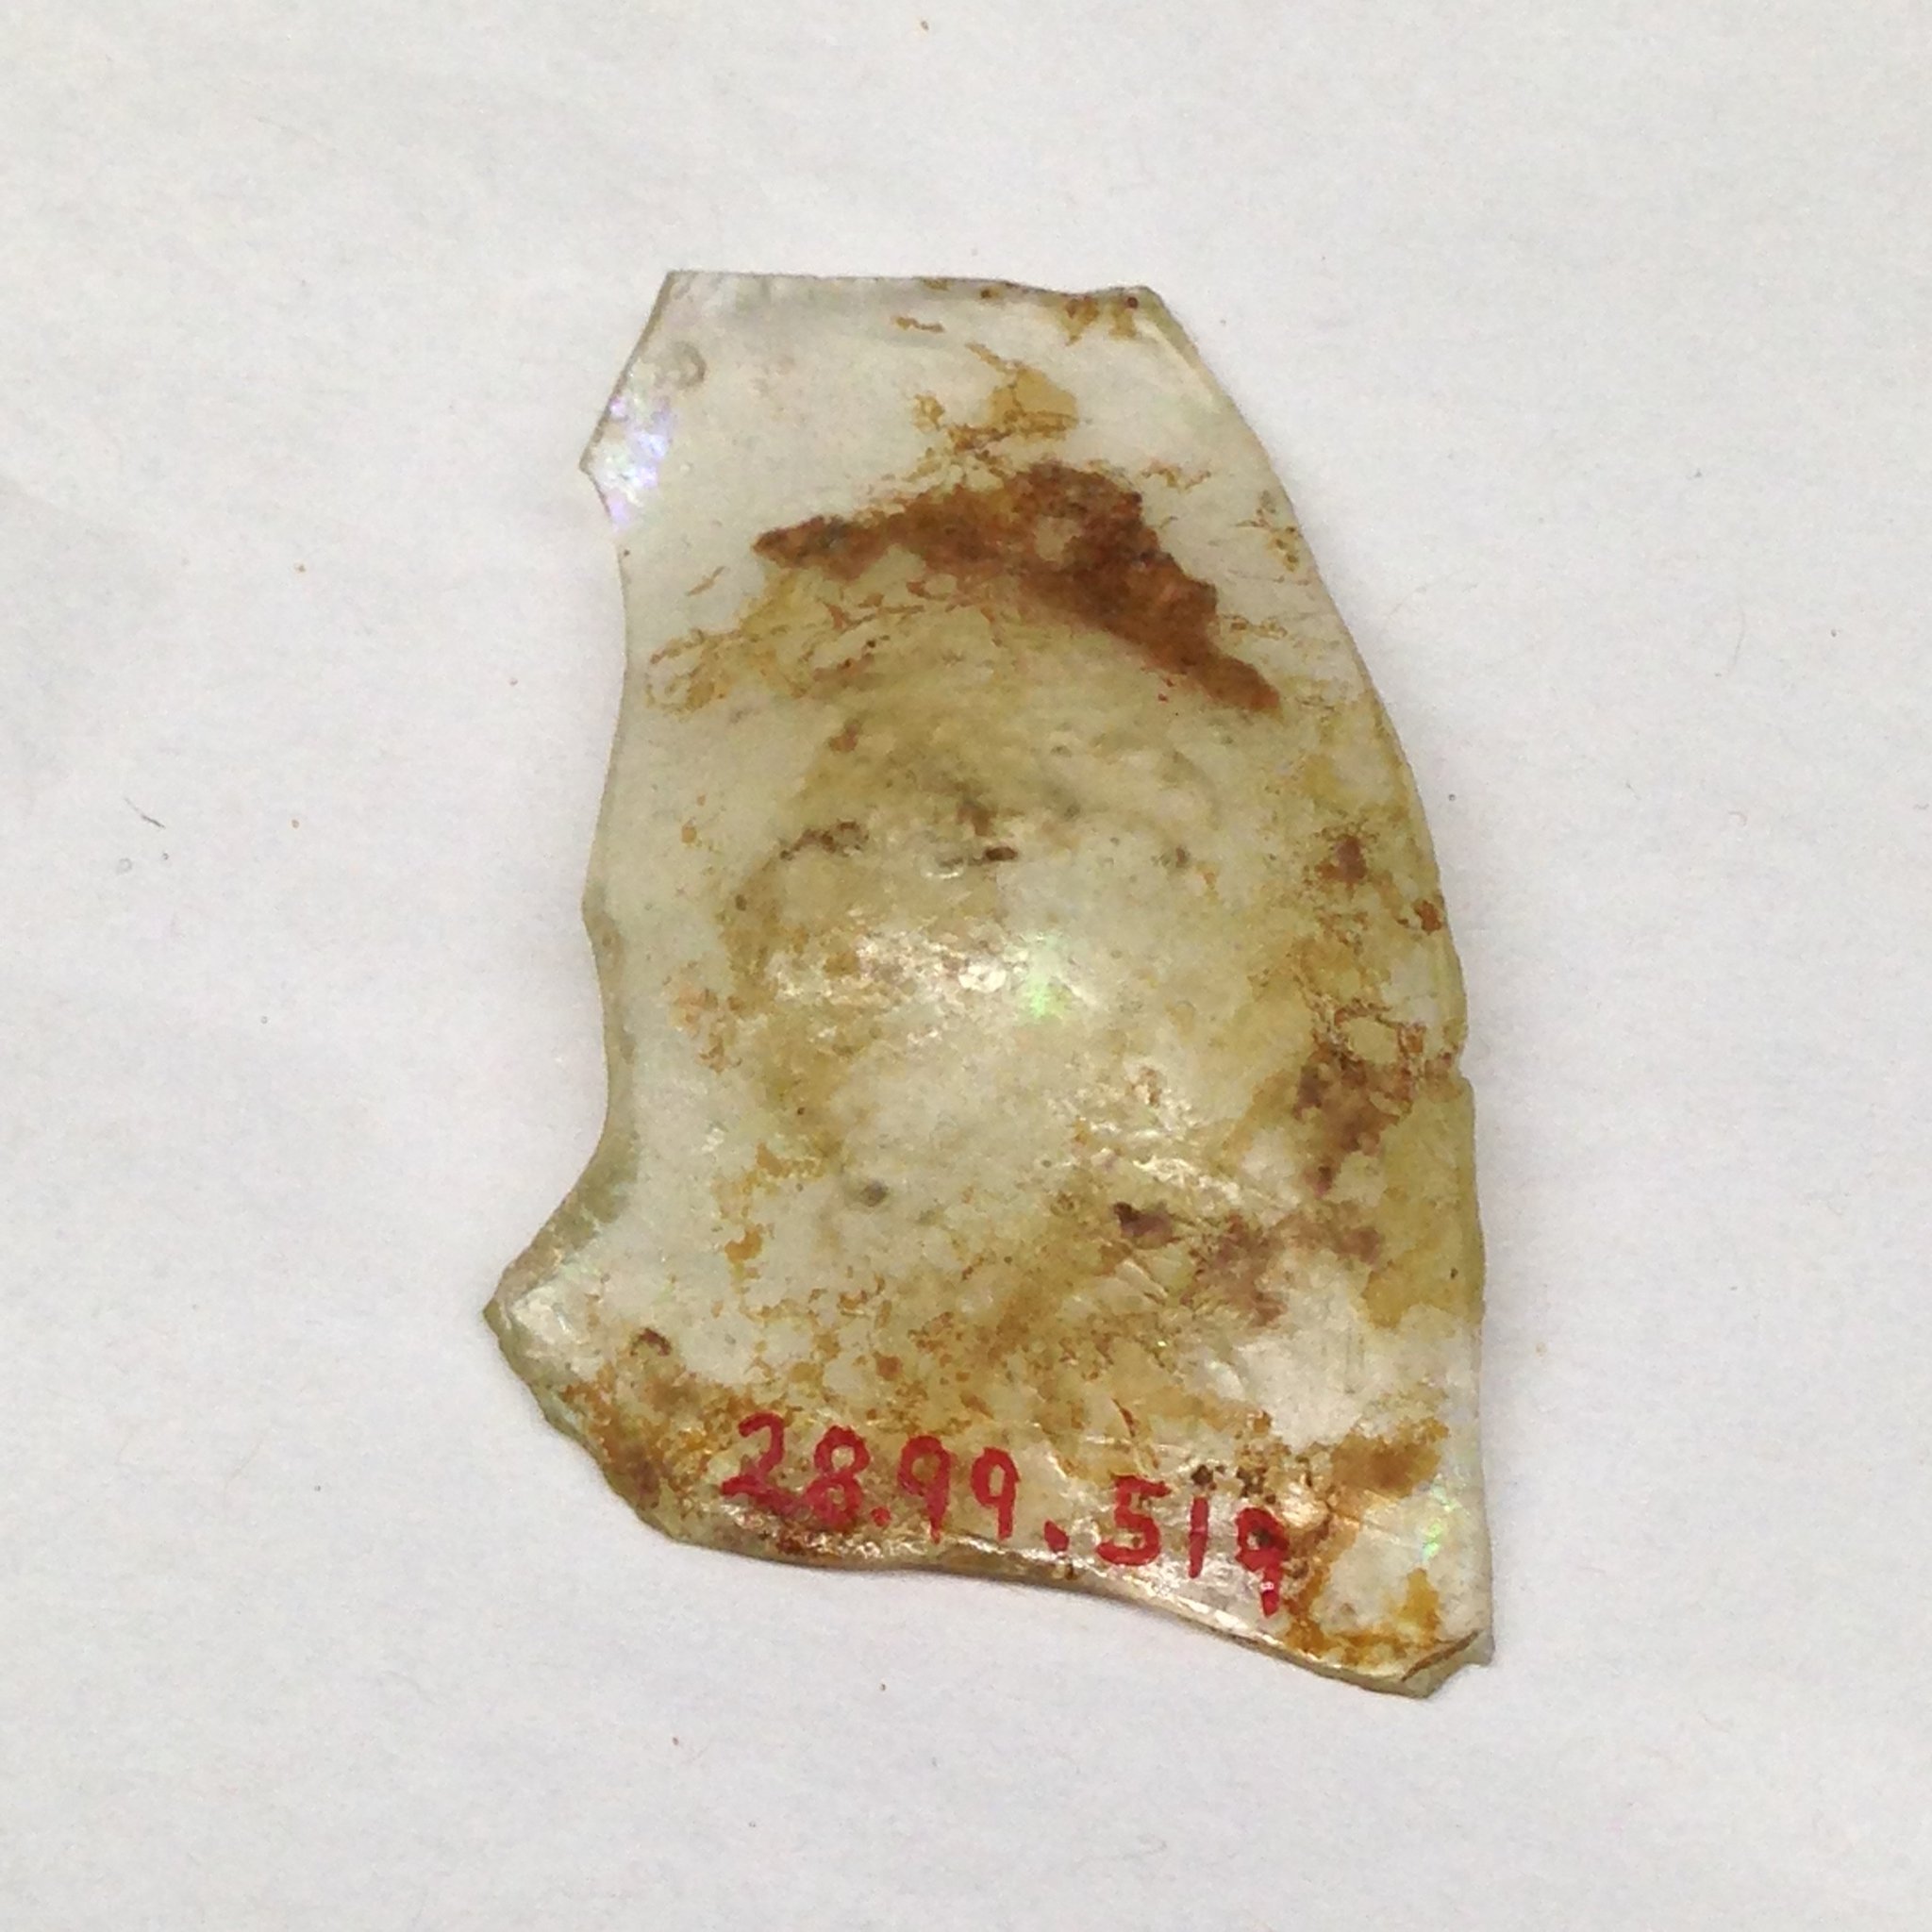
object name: fragment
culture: european or middle eastern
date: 1150-1250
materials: ceramic, glass